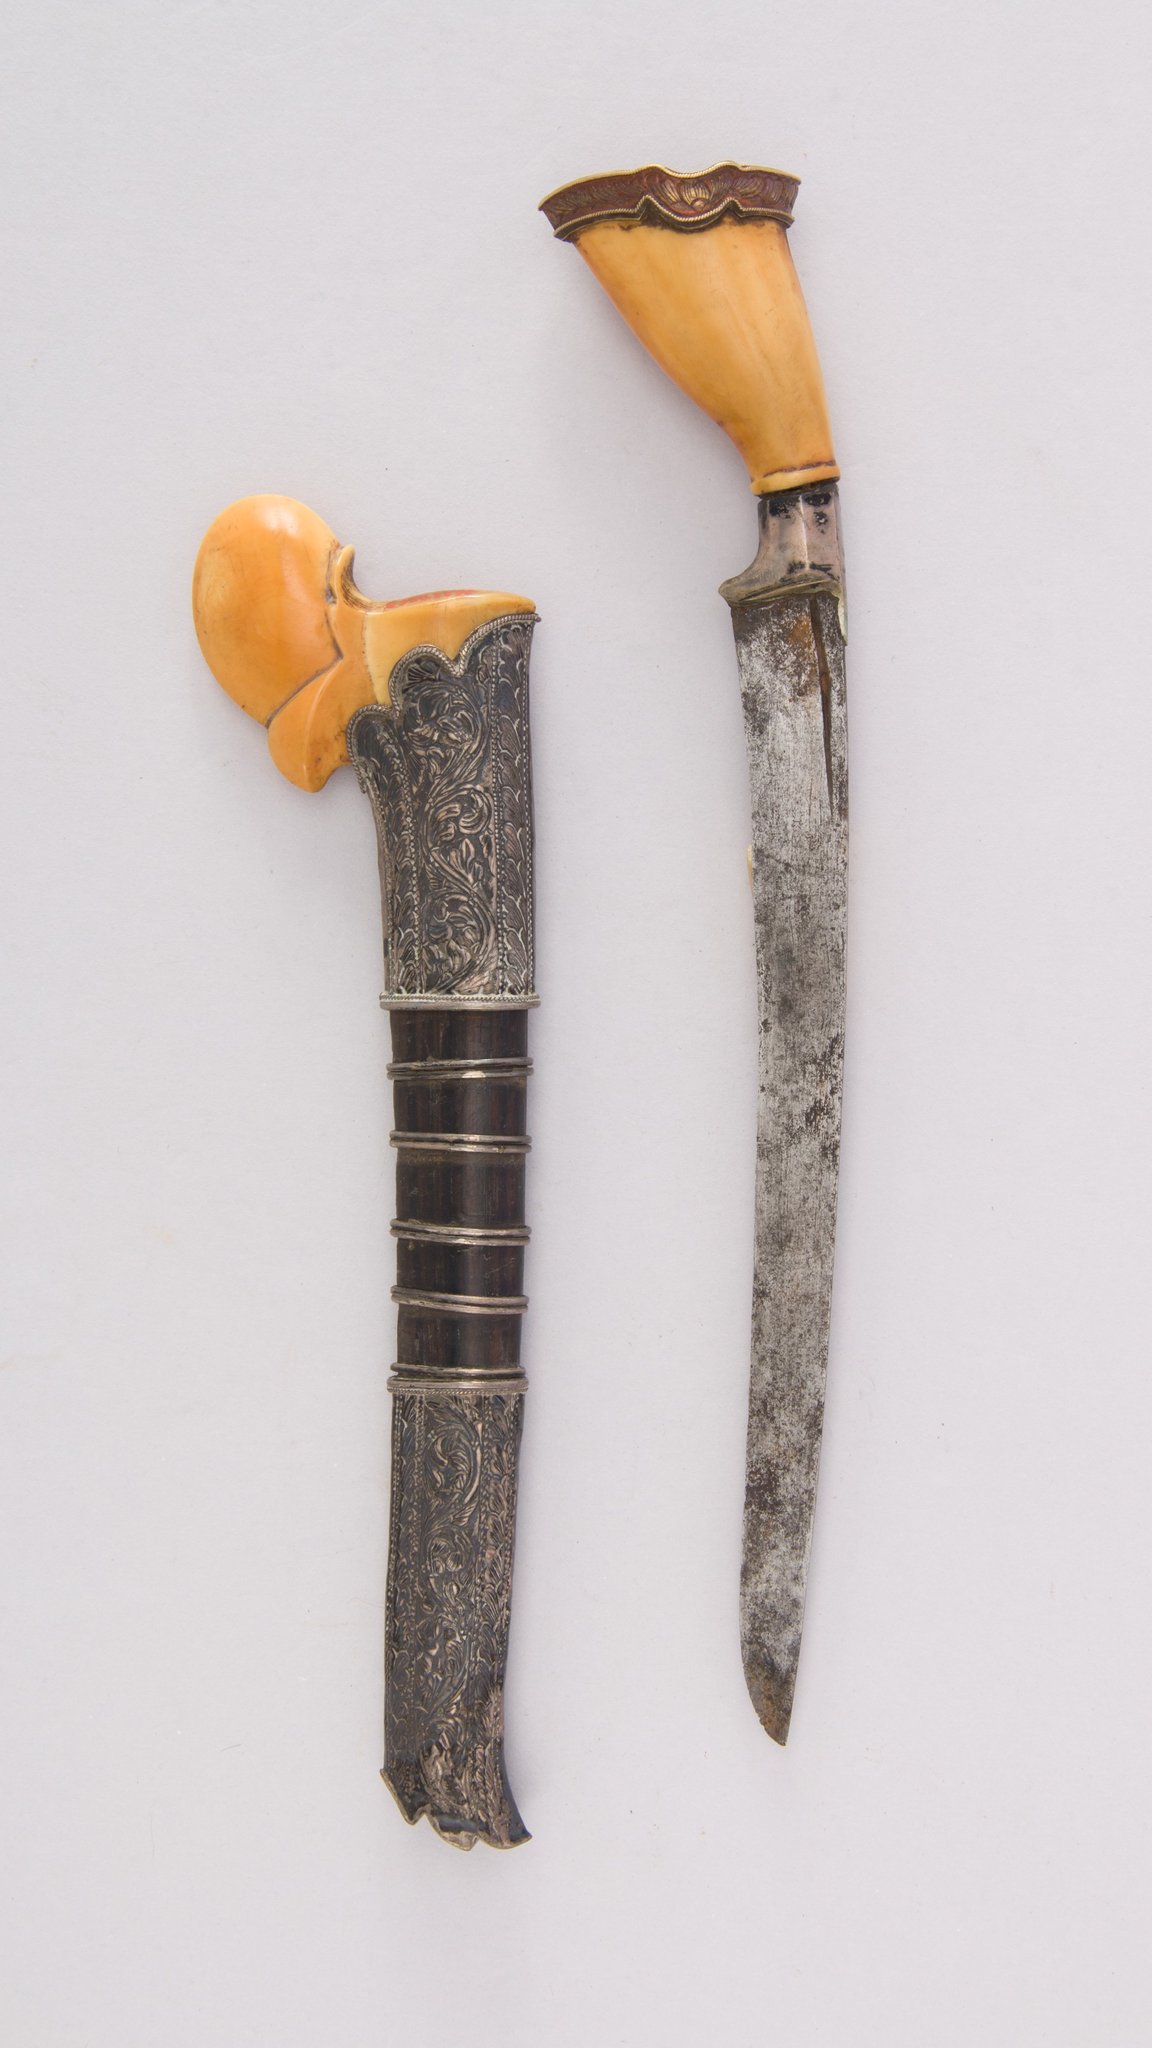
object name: knife bade bade with sheath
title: Knife (Bade-bade) with Sheath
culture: sumatran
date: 1501-1900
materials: ivory, silver, steel, wood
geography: indonesia